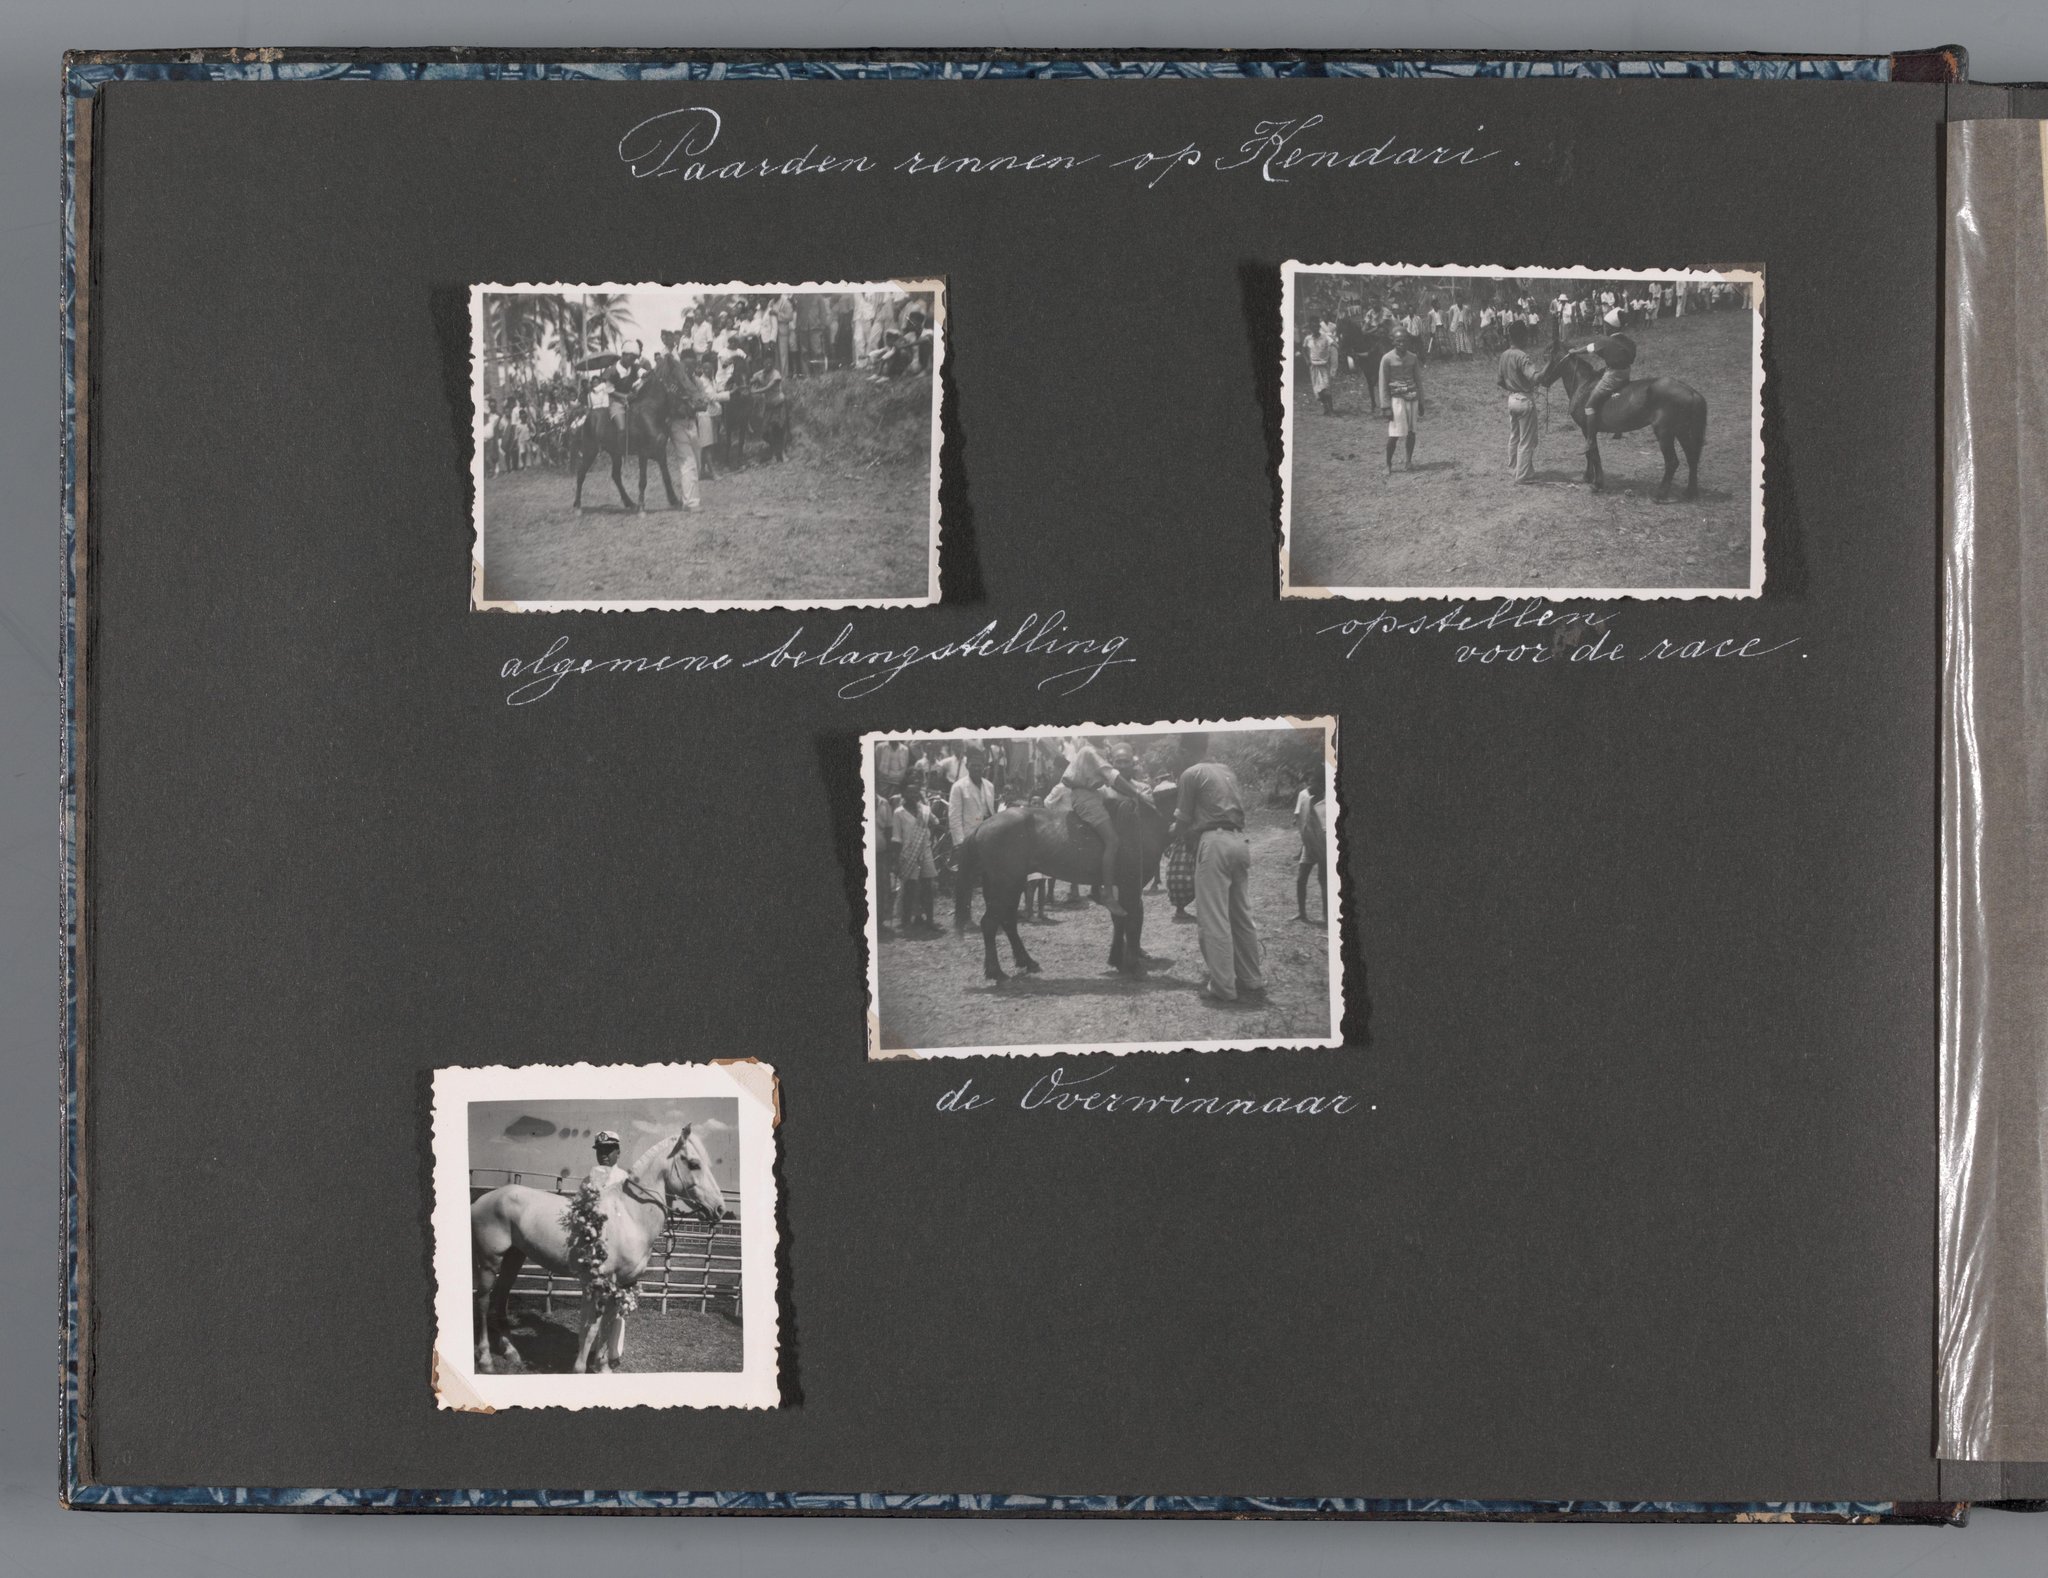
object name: photograph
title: Paarden rennen op Kendari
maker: Anonymous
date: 1935-1938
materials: cardboard, photographic support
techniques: gelatin silver print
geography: celebes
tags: horse-racing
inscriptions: inscription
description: Albumblad met vier foto's van het paardenrennen in Kendari. Onderdeel van het familiealbum van Jet Vonk uit Celebes.